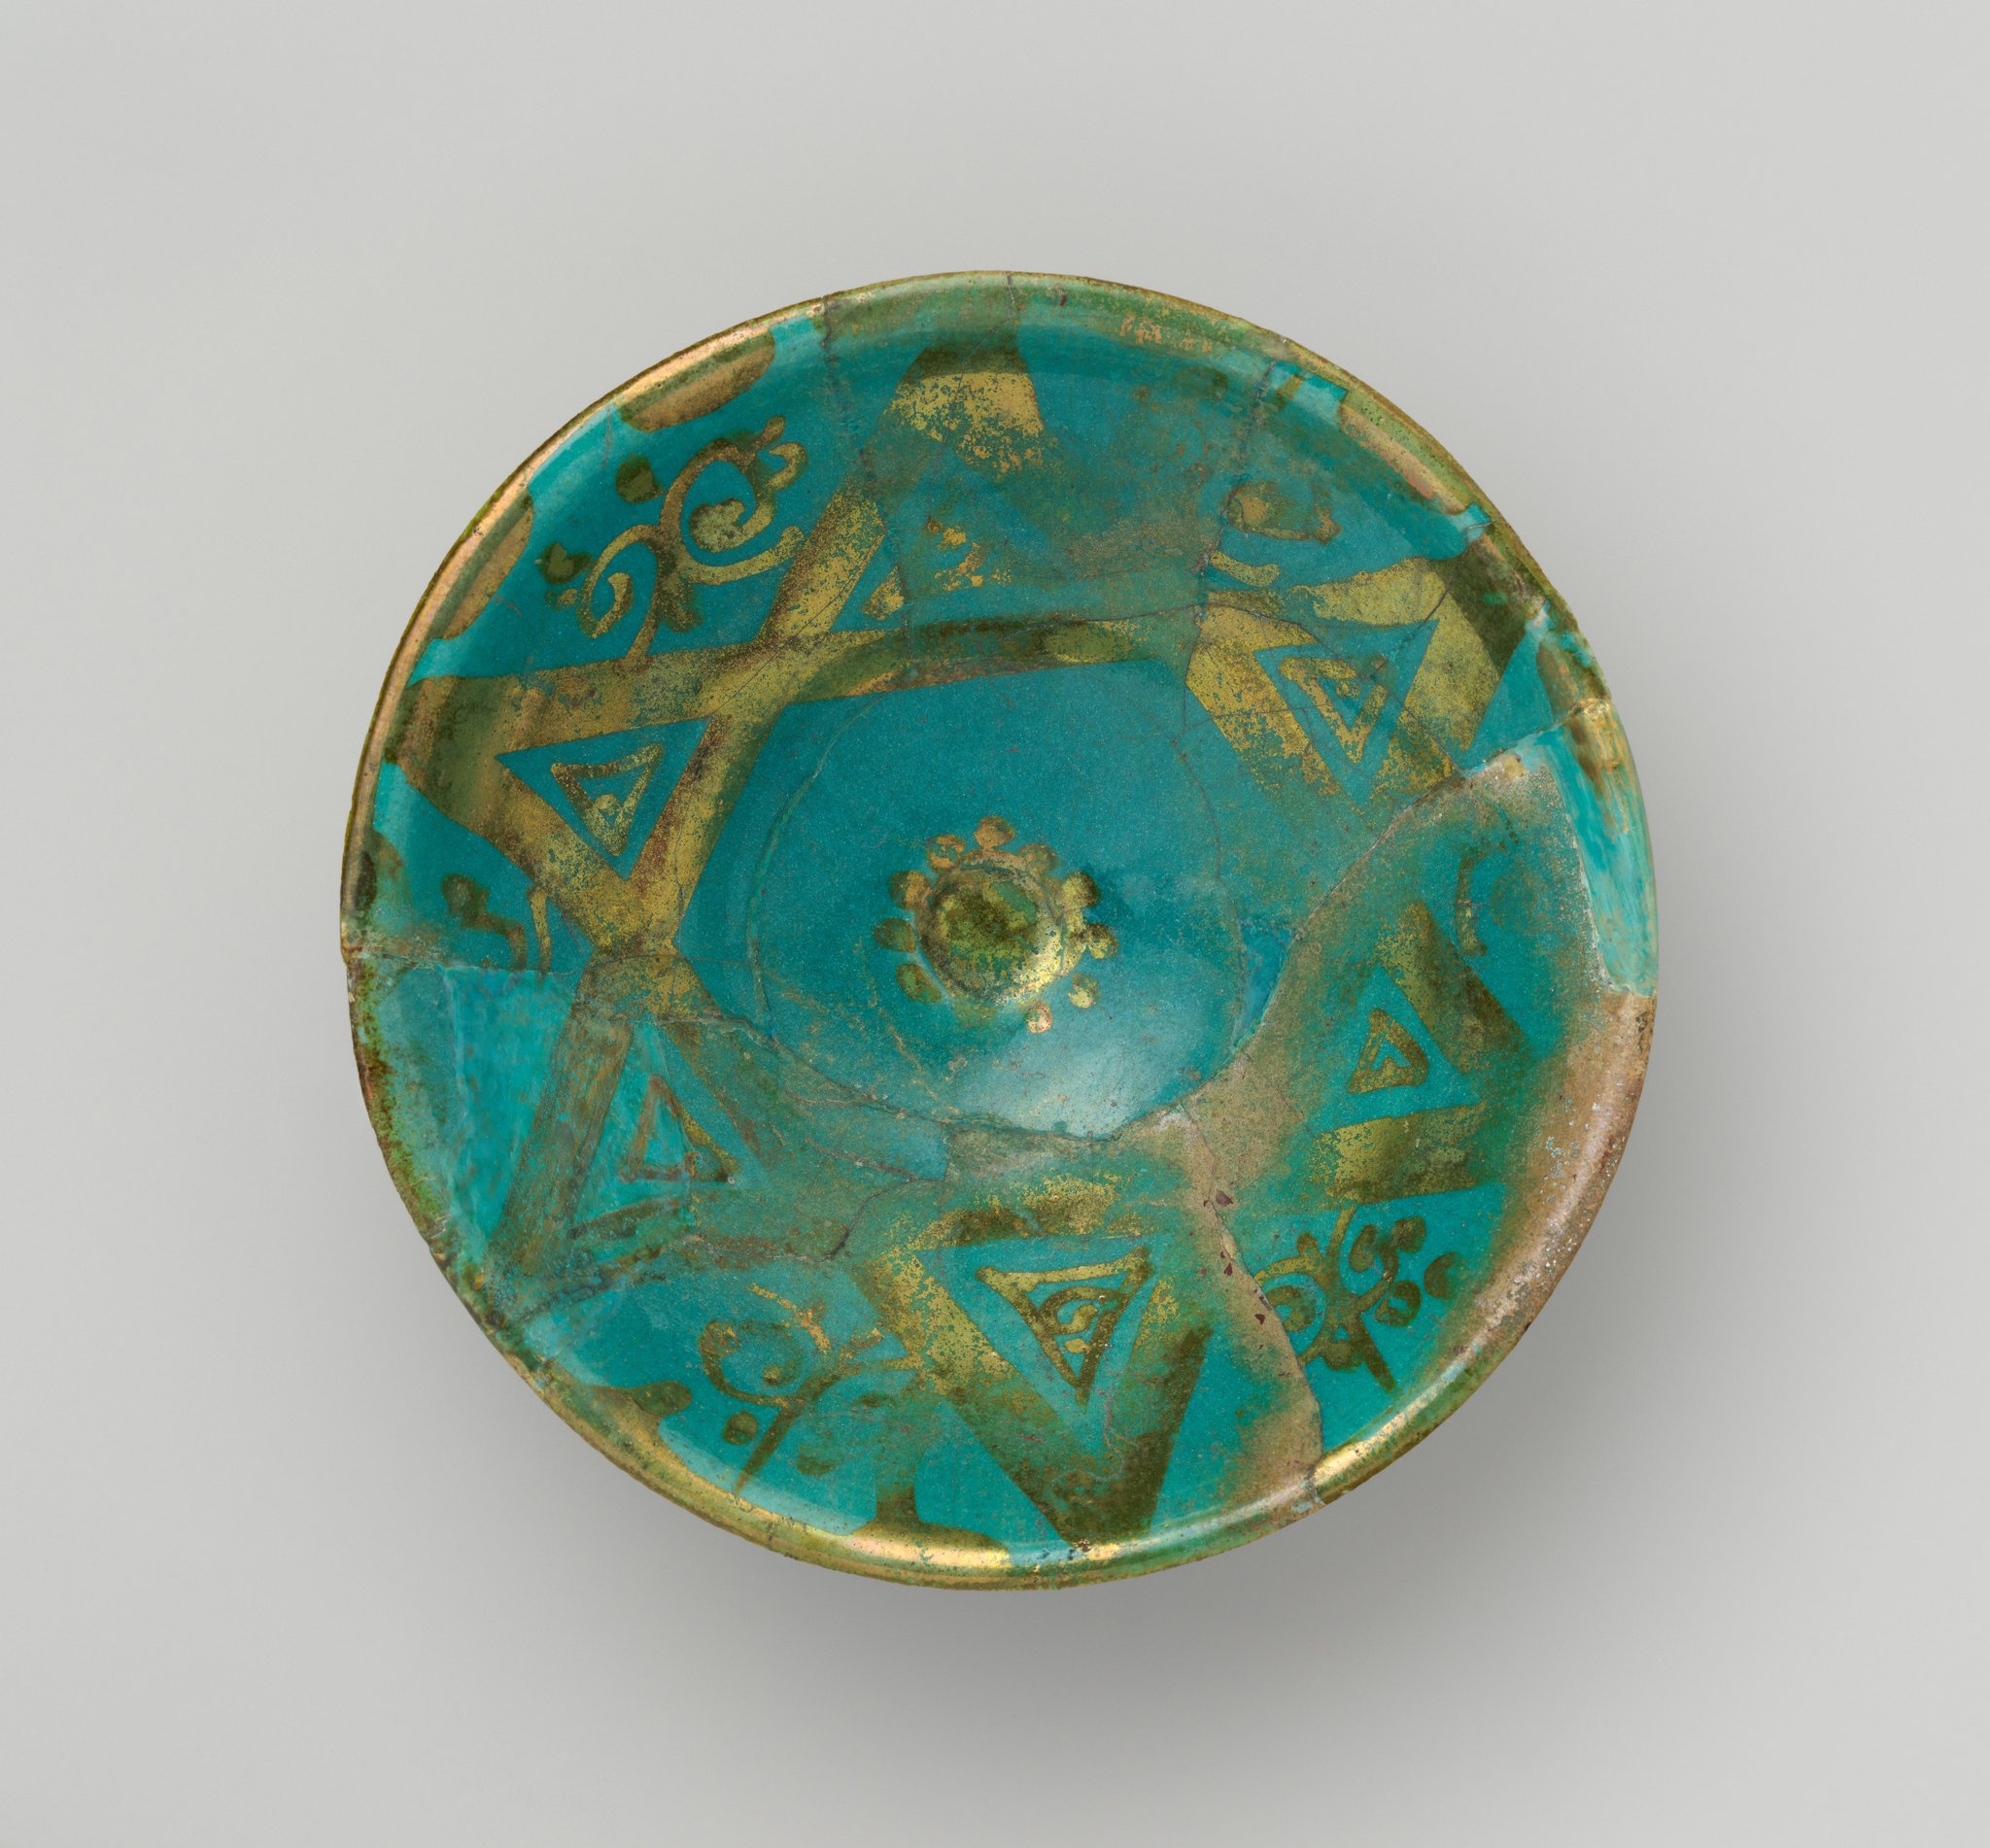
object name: bowl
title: Luster Bowl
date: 1134-1166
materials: stonepaste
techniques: luster painting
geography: syria